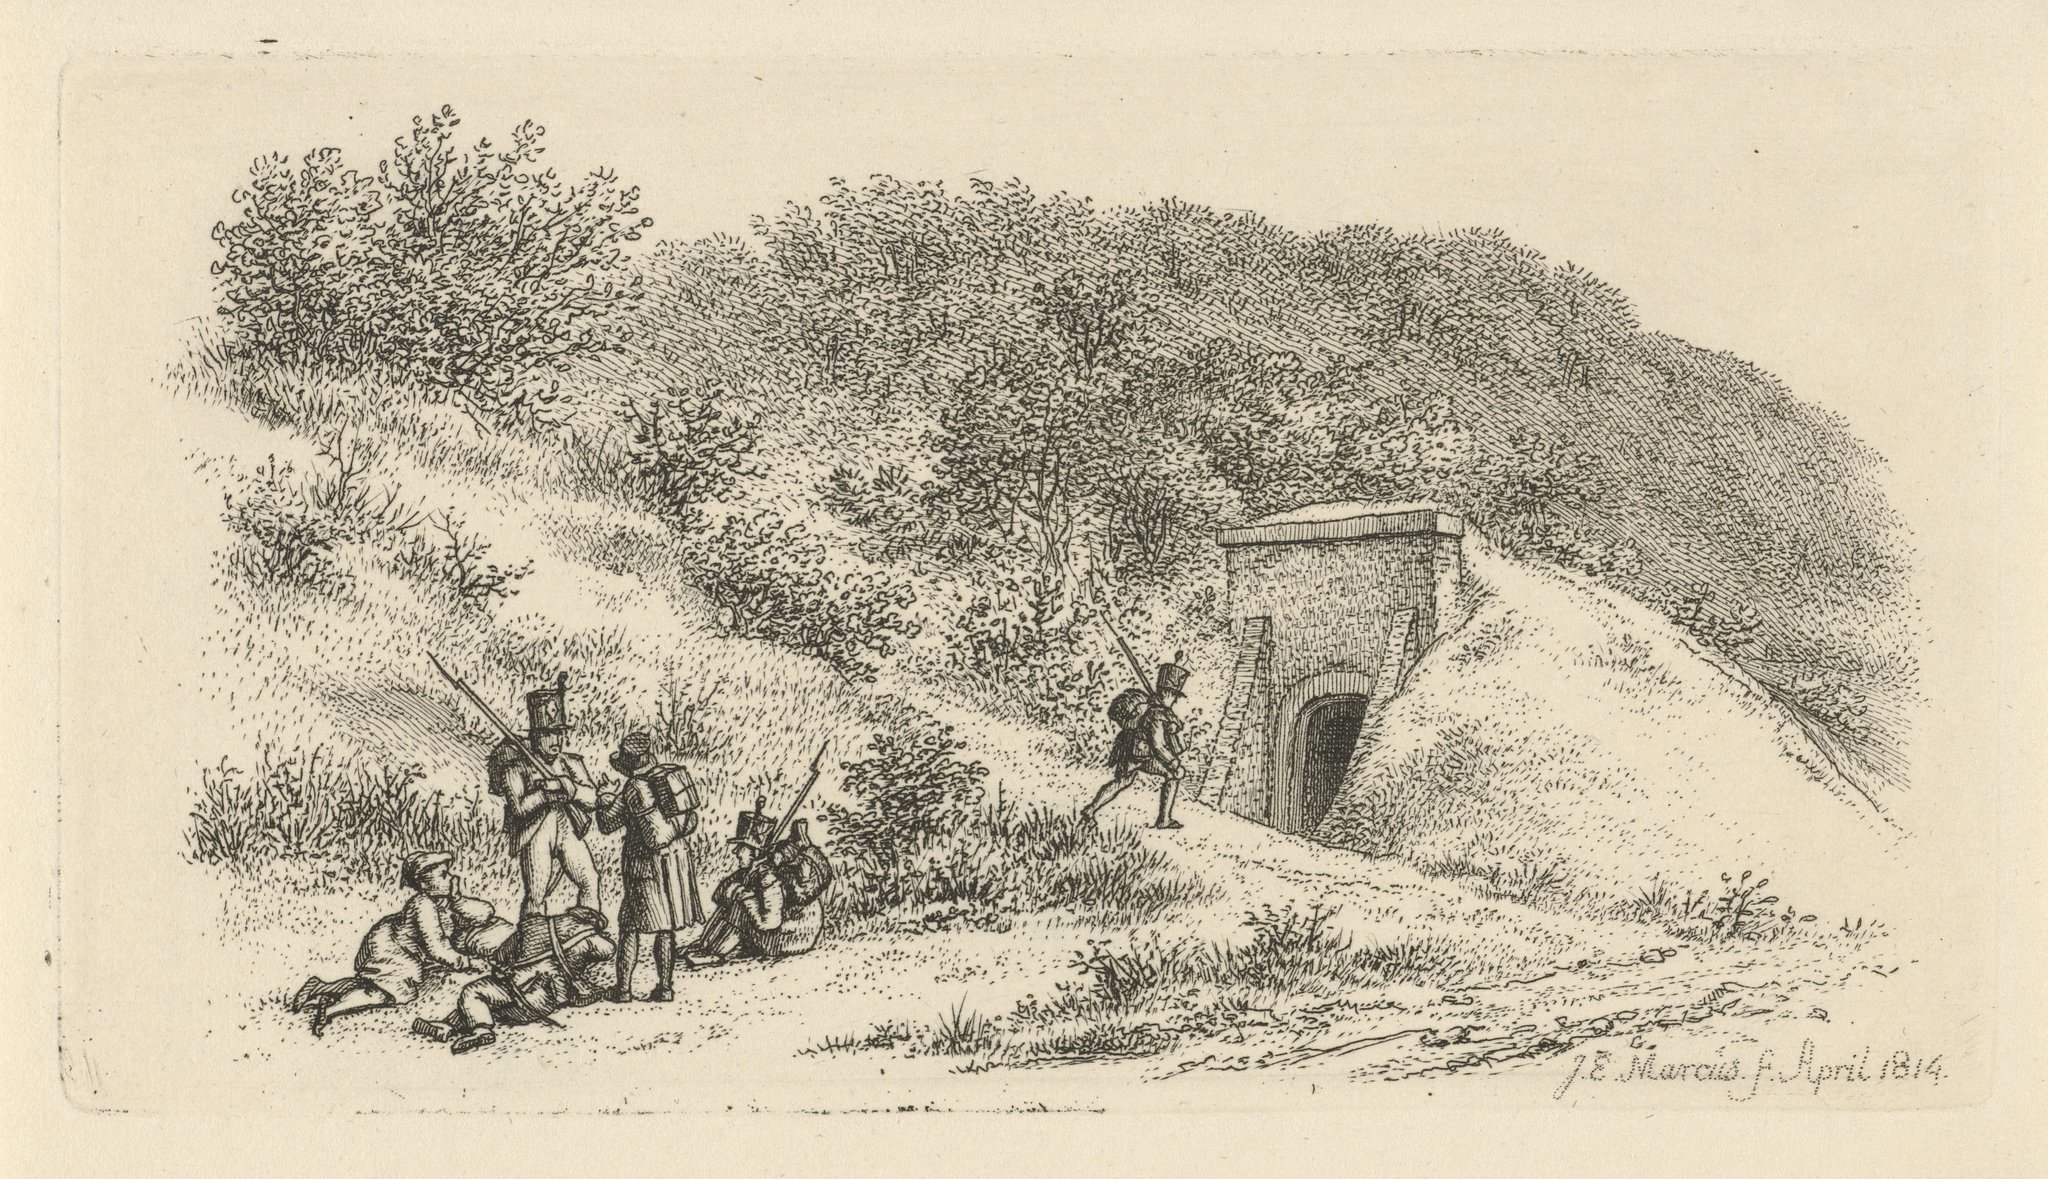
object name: print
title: Studie-prentwerk / Etudes gravées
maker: jacob ernst marcus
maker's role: draughtsman, print maker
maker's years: 1774-1826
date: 1804-1814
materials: paper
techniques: etching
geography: amsterdam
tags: the soldier; the soldier's life (+ outside city-wall or fortress)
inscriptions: collector's mark: Lugt 2228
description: Serie voor het eerst uitgegeven door Jacob Ernst Marcus onder de titel Studiebeelden en Fragmenten. Amsterdam: ca.1816. Later heruitgegeven als: Studie-prentwerk/ Etudes gravées.